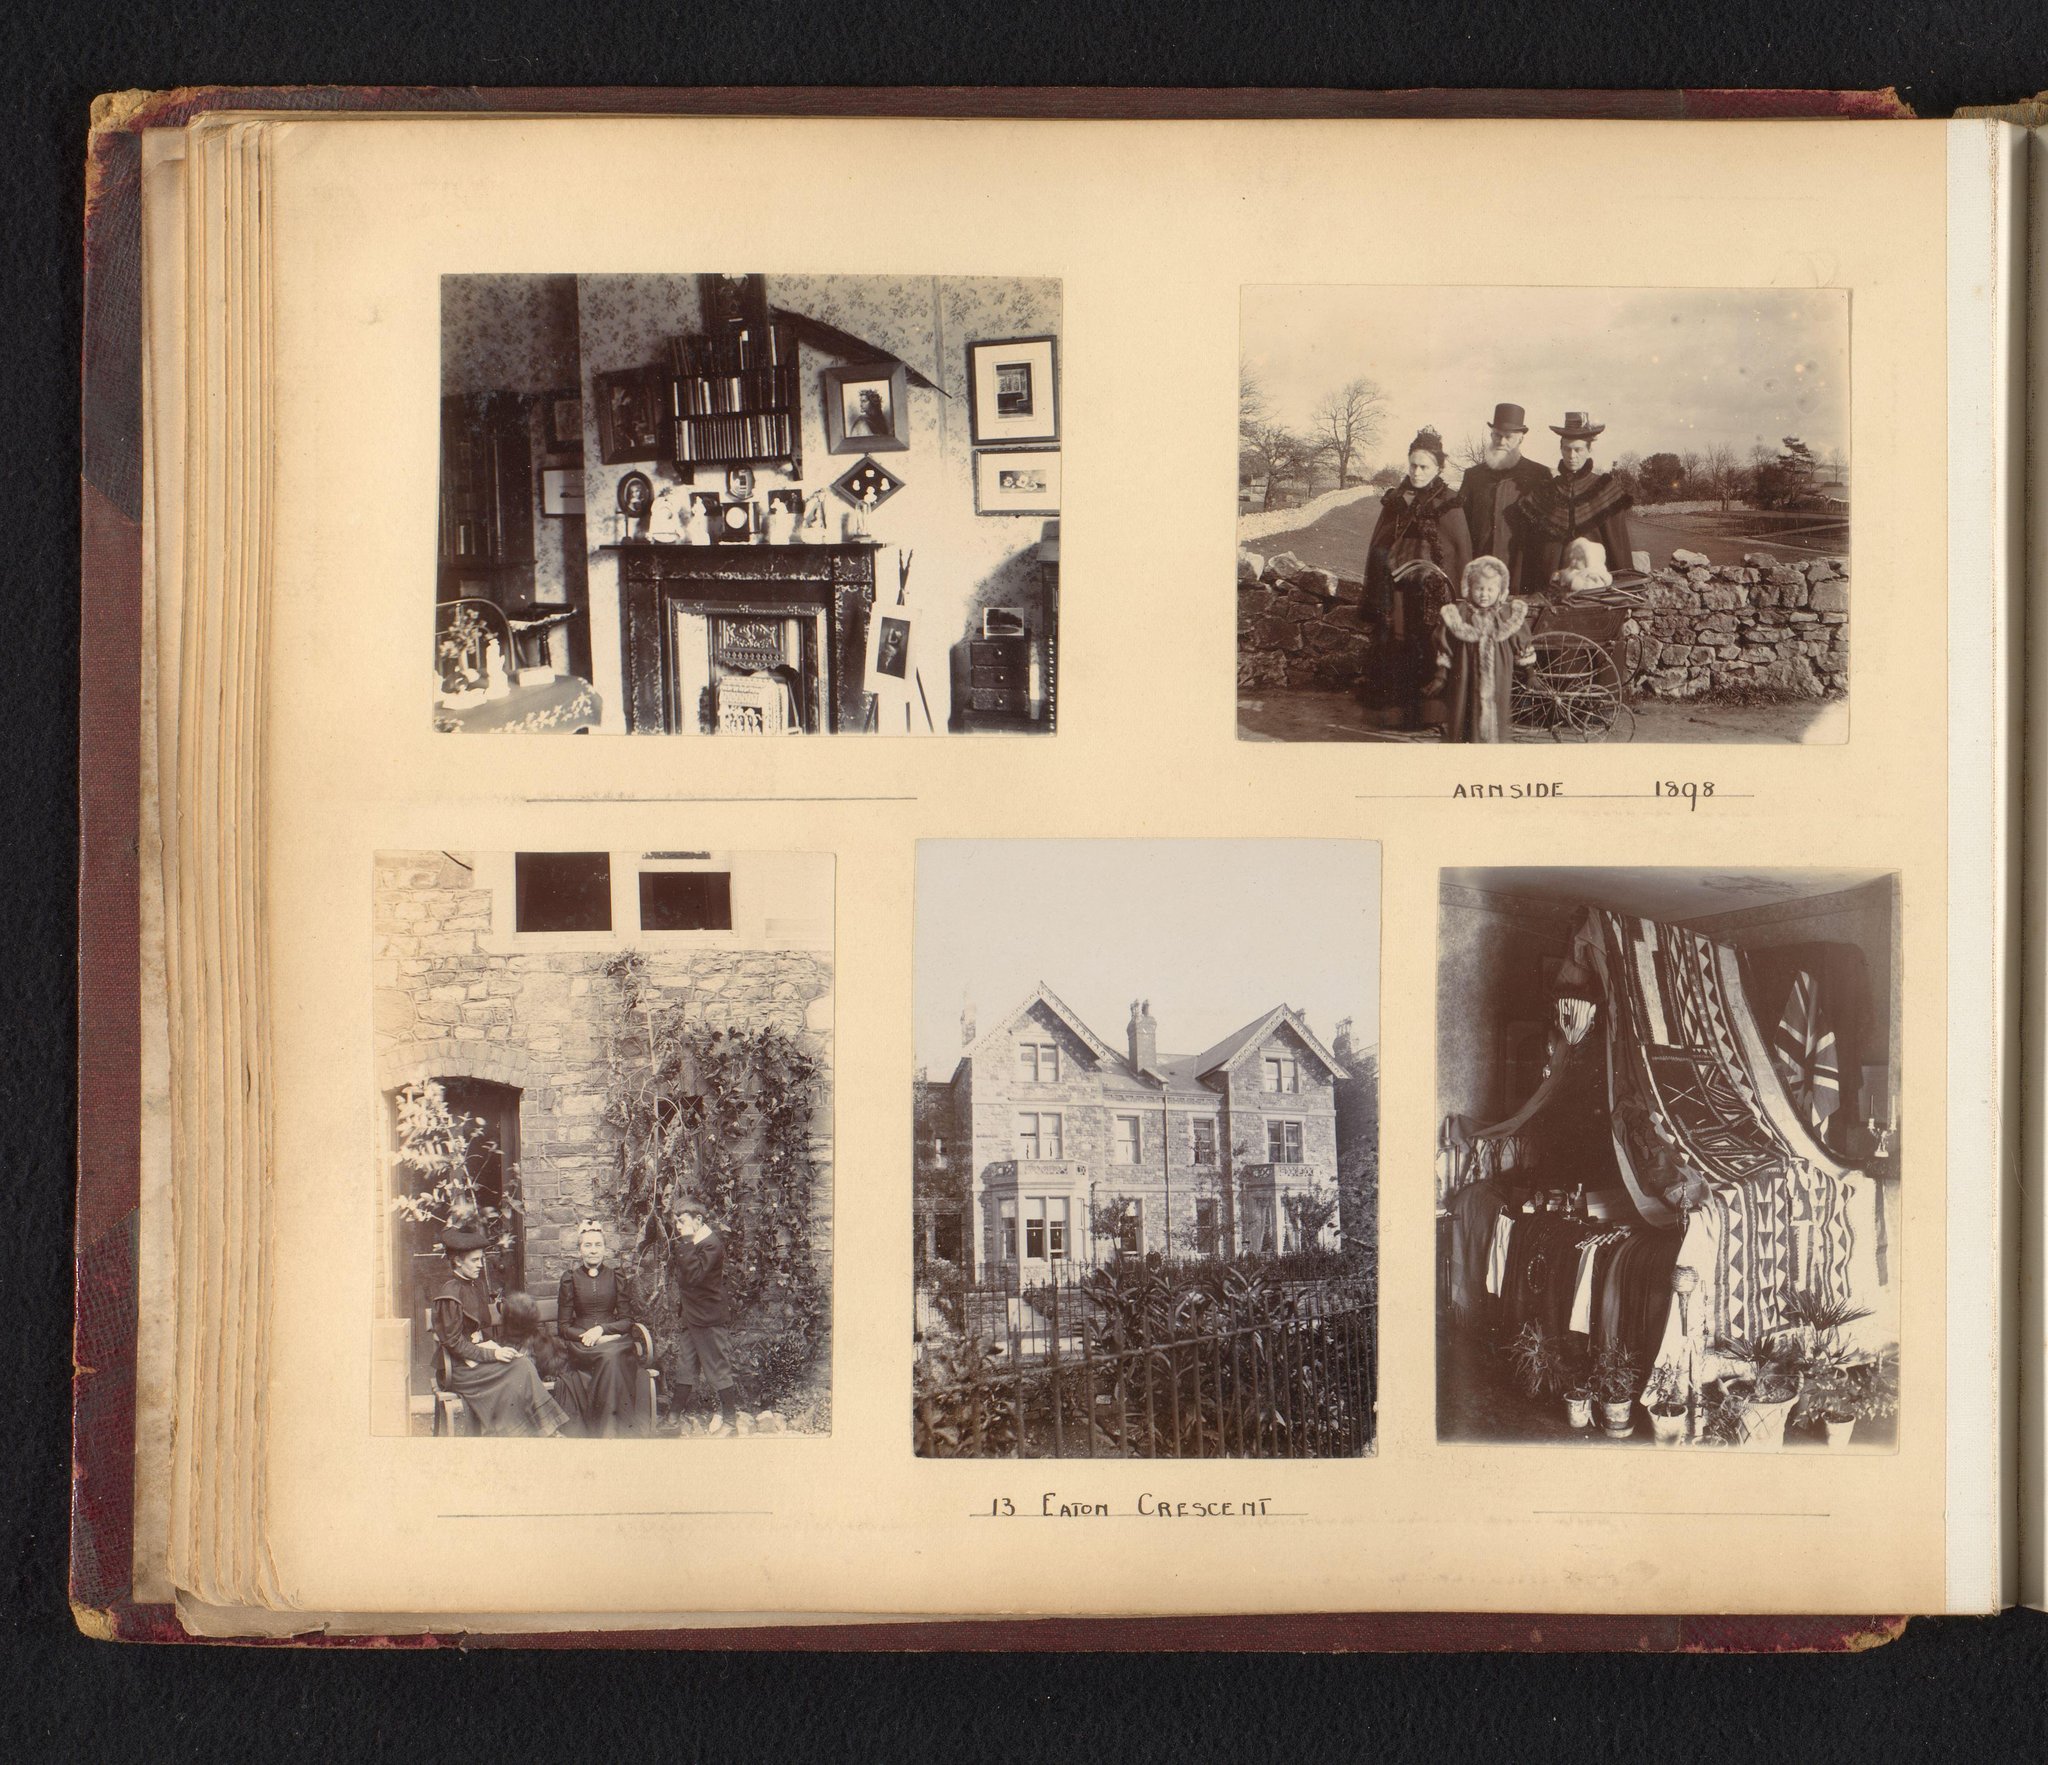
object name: photograph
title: Diverse onderwerpen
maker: Anonymous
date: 1890-1898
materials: photographic support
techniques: collodion silver print, gelatin silver print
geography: england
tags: interior of the house, family, descendance, bedroom, front façade, england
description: Interieur van een woning, een familieportret te Arnside, twee vrouwen met een kind en hond op in een tuin, een woning en een slaapkamer. Deze pagina maakt deel uit van een album.